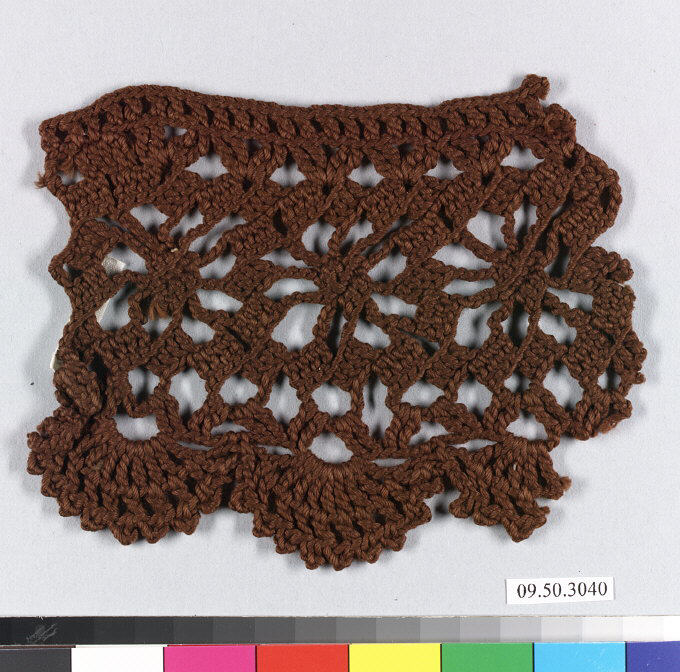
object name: sample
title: Crochet Work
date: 1801-1900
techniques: crochet